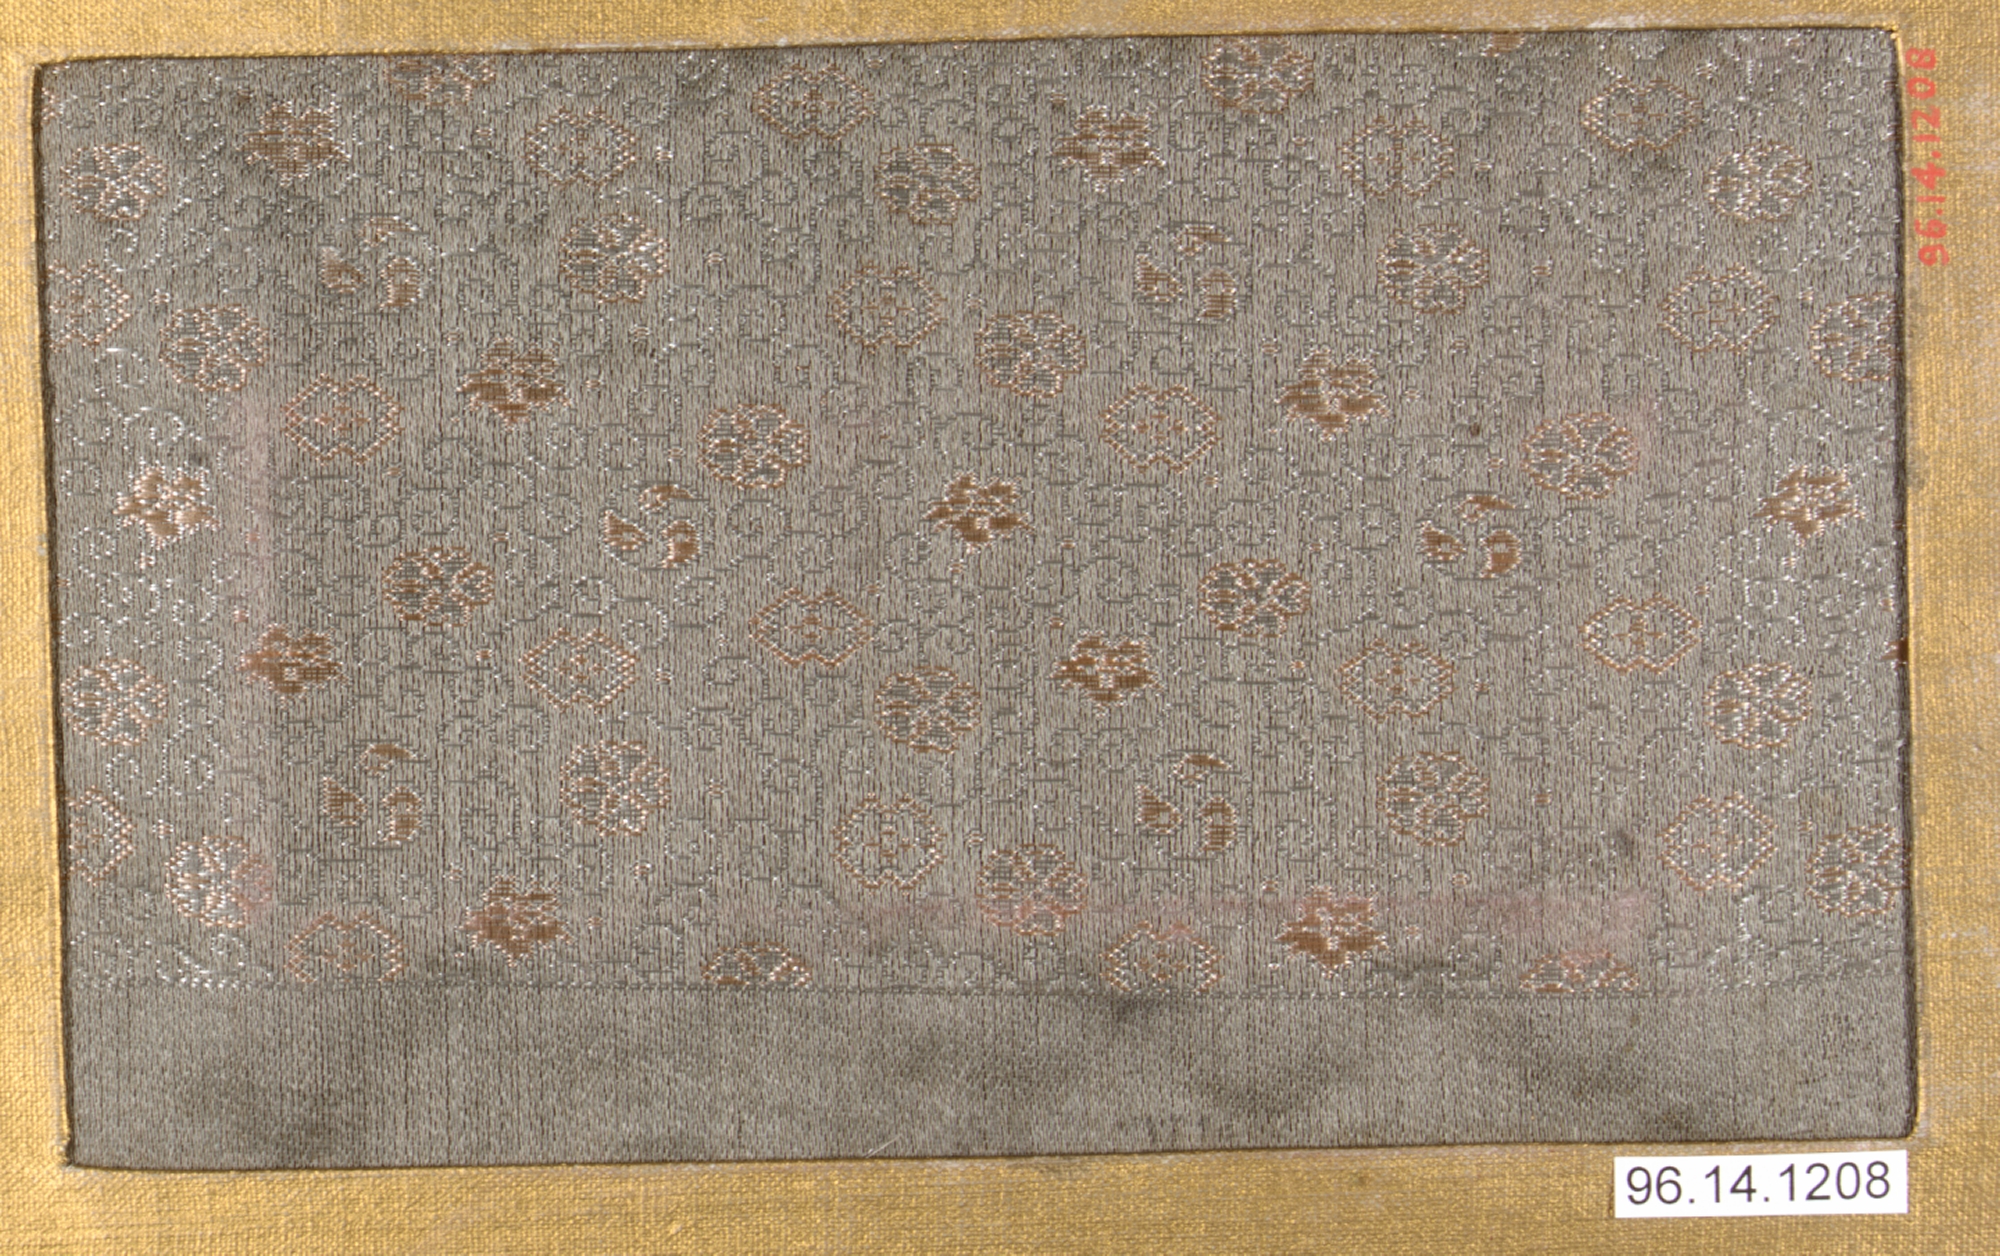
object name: piece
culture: japanese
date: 1701-1900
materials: silk